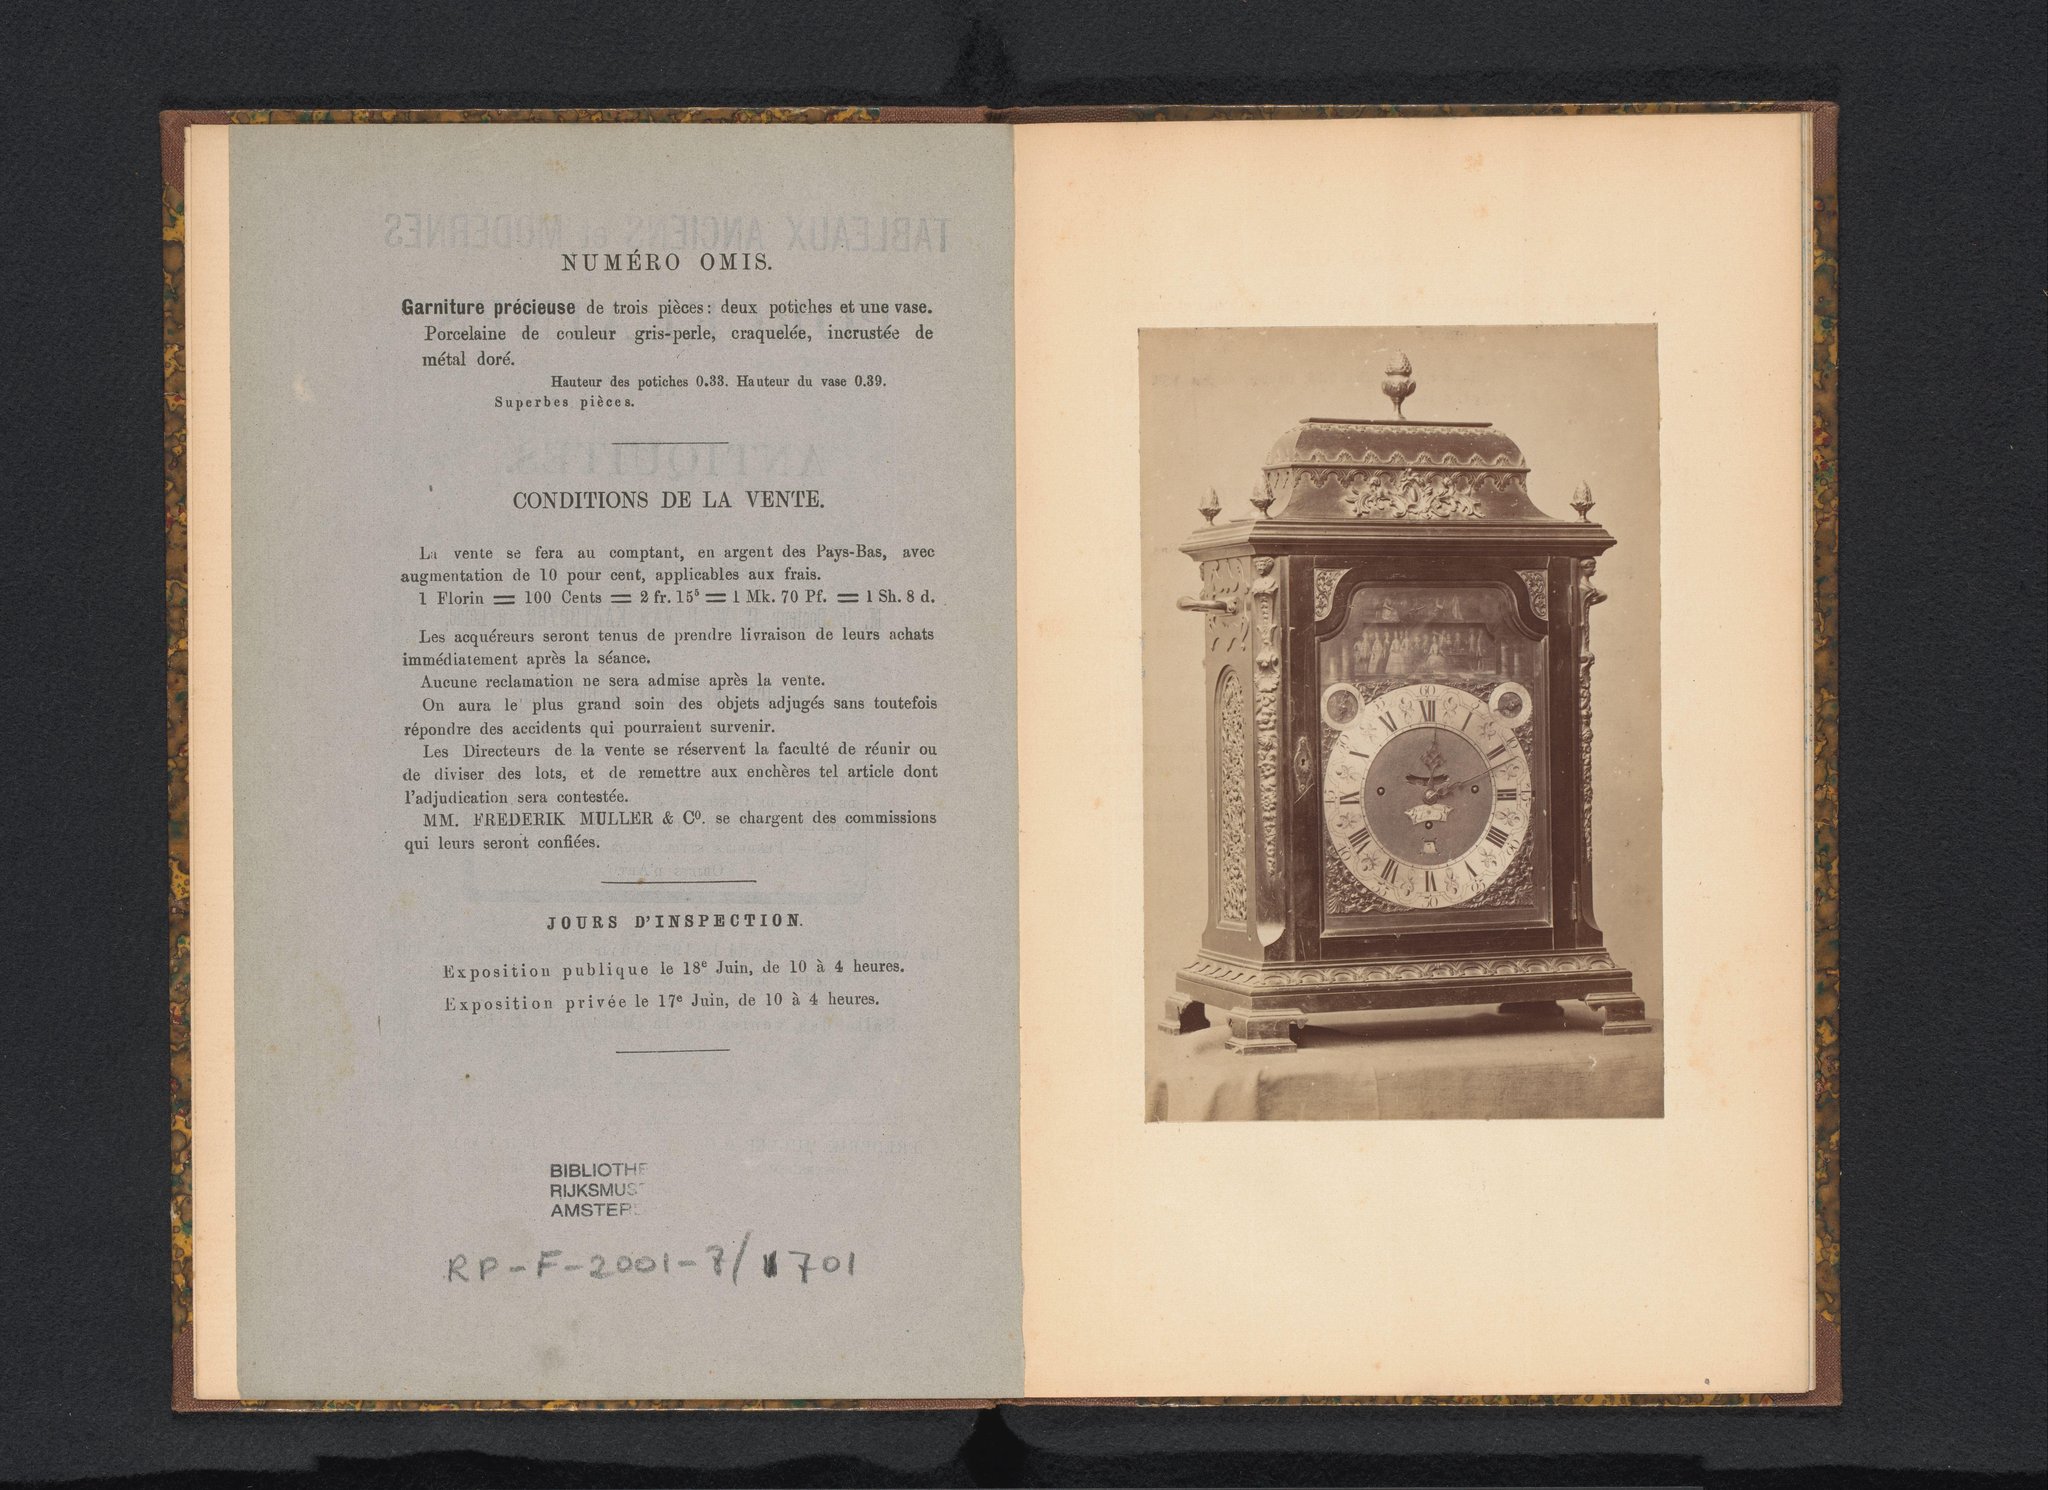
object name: photograph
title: Klok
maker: Anonymous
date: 1874-1879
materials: photographic support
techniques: albumen print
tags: clock